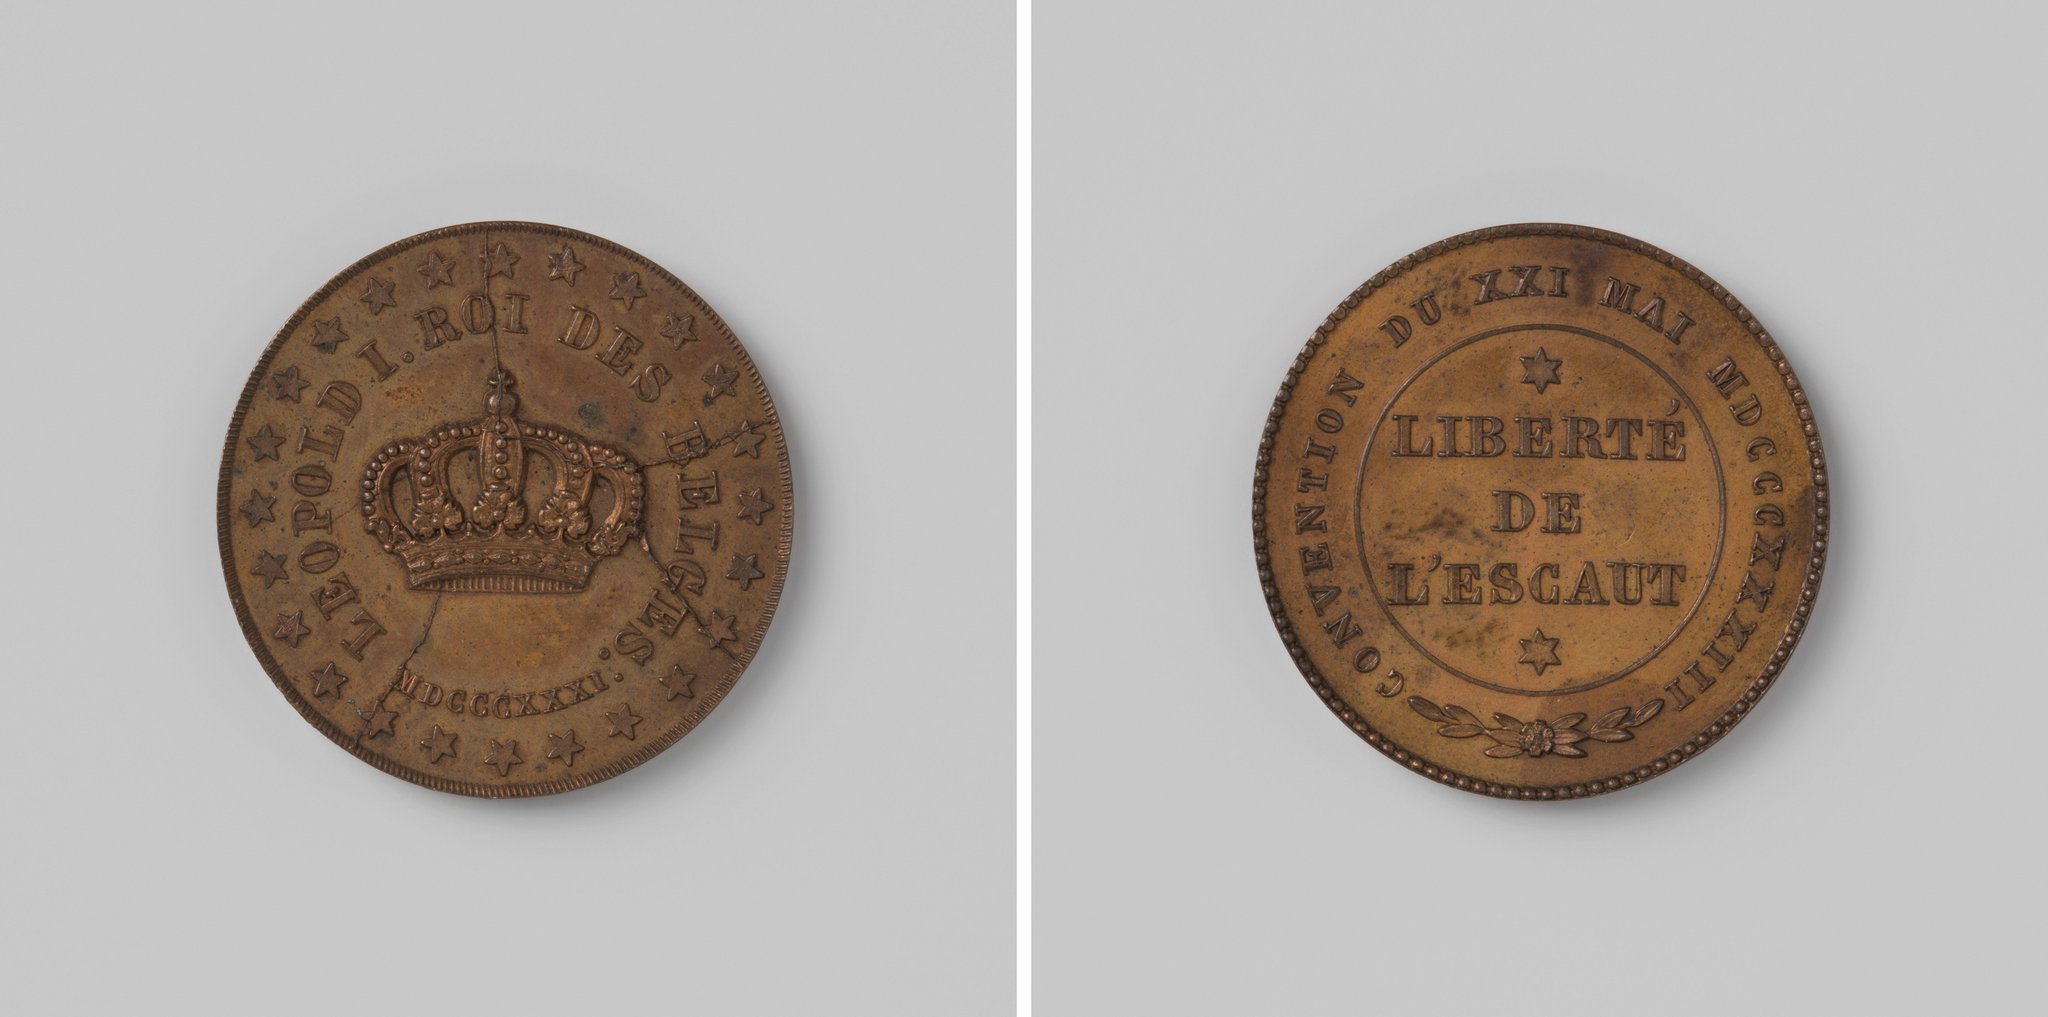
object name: strooipenning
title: Conventie over de Schelde te Londen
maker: laurent joseph hart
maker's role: die cutter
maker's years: 1810-1860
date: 1833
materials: bronze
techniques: striking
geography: brussels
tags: paris, charles maurice hertog van talleyrand-périgord, laeken, leopold i (koning der belgen), politician, london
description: Bronzen penning. Voorzijde: kroon binnen omschrift en sterrekrans. Keerzijde: opschrift tussen twee sterrenbinnen omschrift